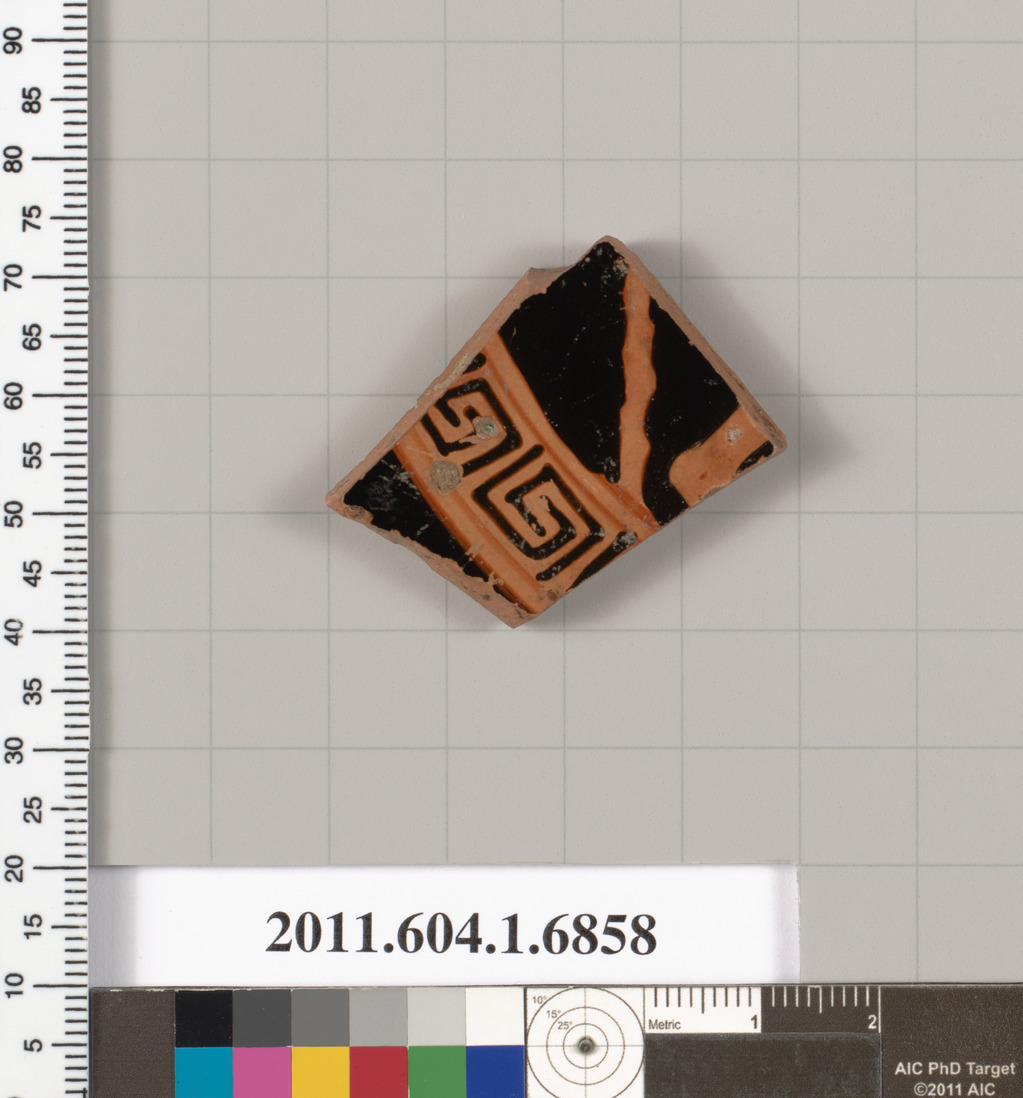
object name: kylix fragment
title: Terracotta fragment of a kylix (drinking cup)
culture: greek, attic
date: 490-470 BCE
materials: terracotta